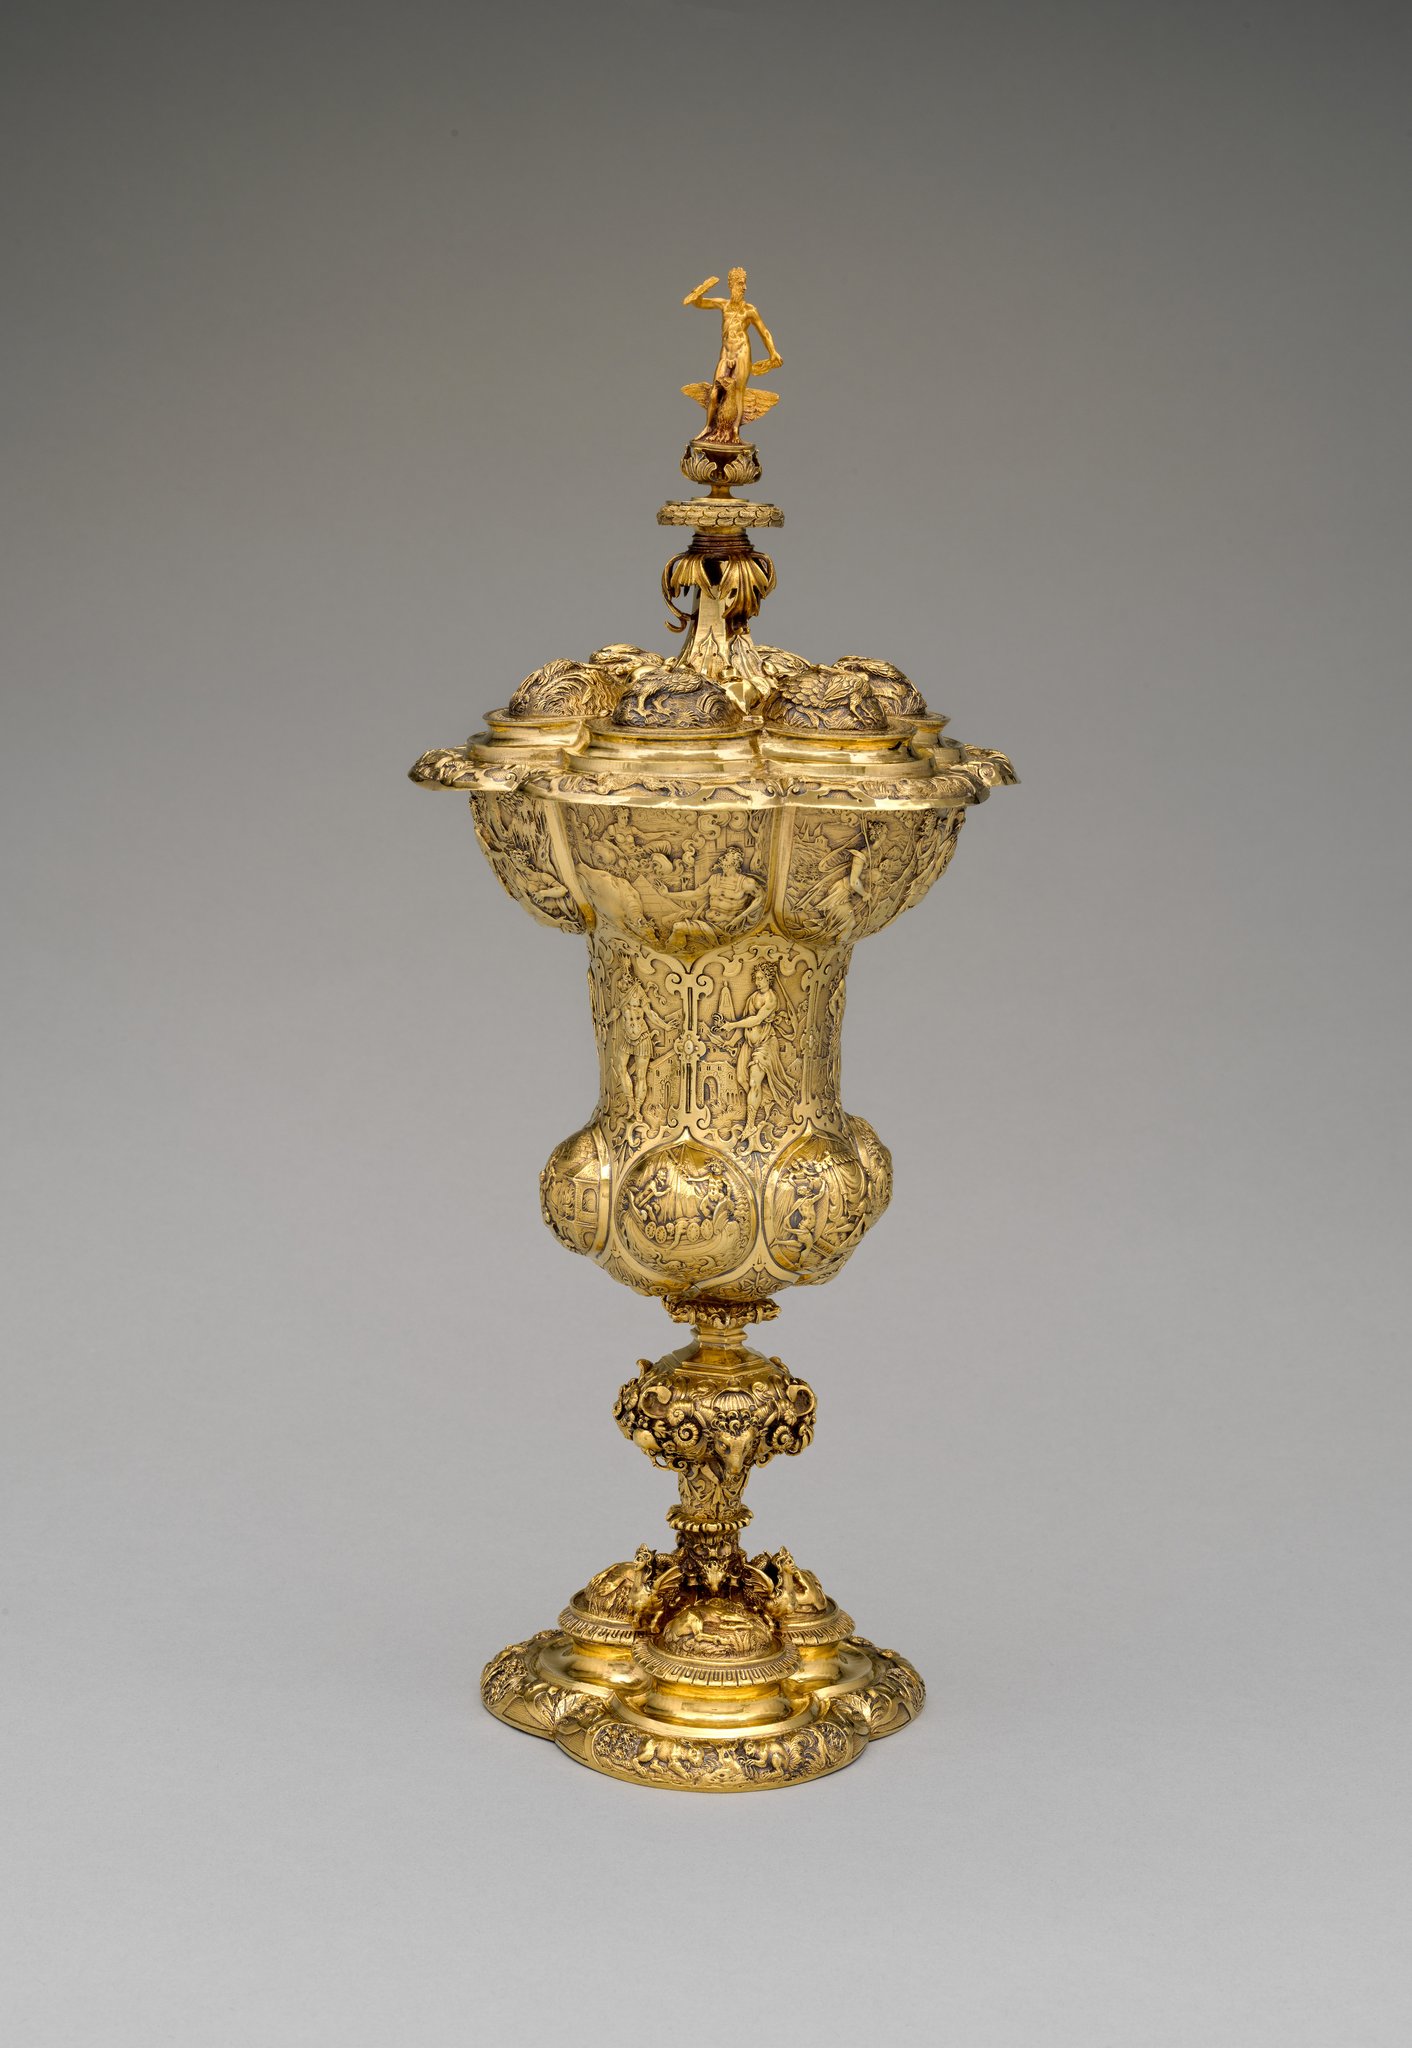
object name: cup with cover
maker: hans (?) jamnitzer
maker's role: maker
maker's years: 1561-1603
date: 1801-1900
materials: silver gilt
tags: birds,jupiter